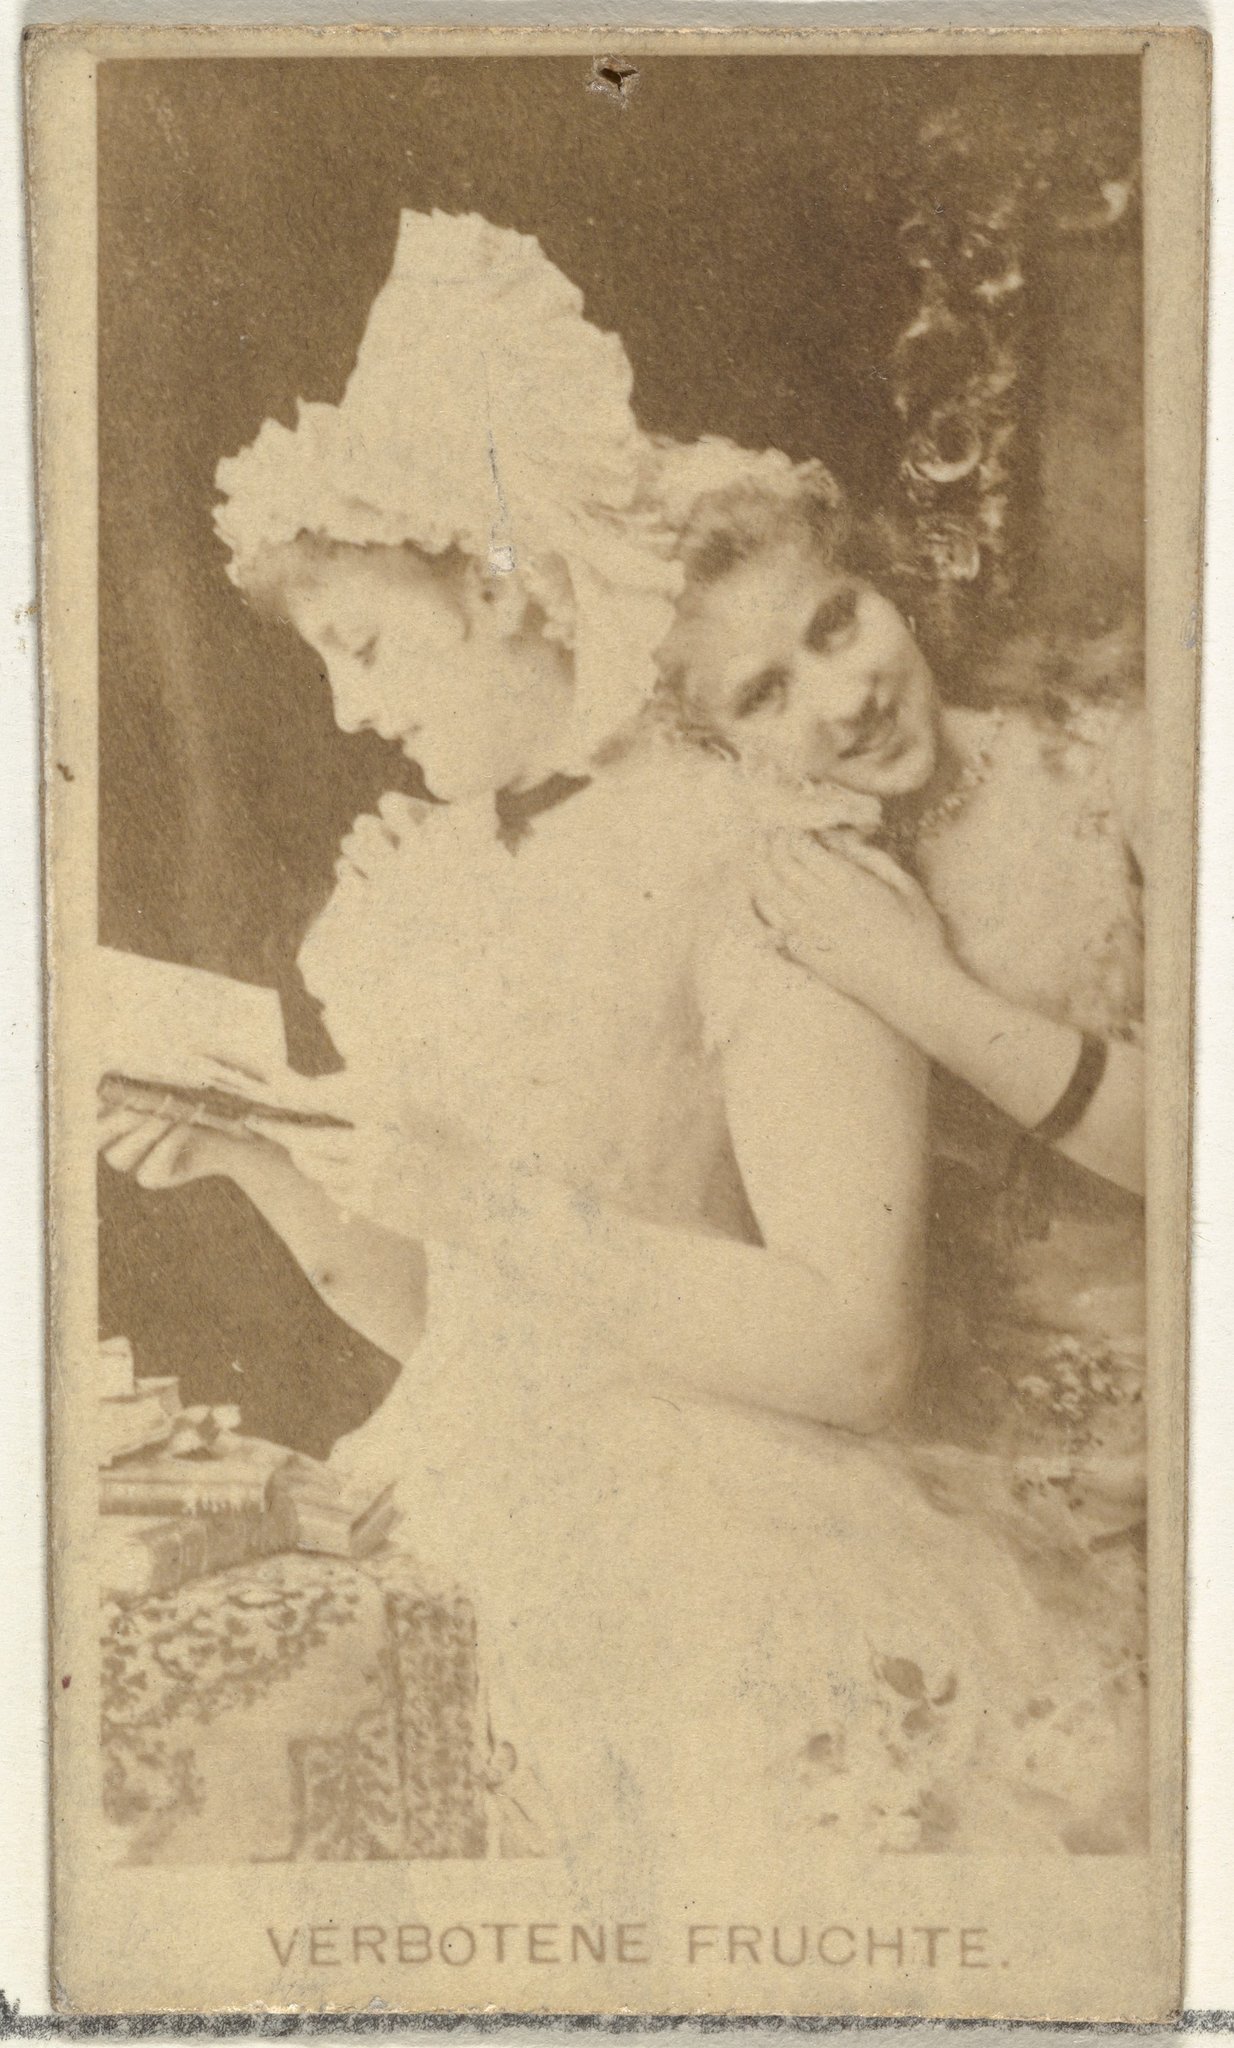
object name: photograph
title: Verbotene Fruchte, from the Actors and Actresses series (N145-8) issued by Duke Sons & Co. to promote Duke Cigarettes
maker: w. duke, sons & co.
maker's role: publisher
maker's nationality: american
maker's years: 1870-1920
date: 1891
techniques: albumen silver print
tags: portraits,women,actresses